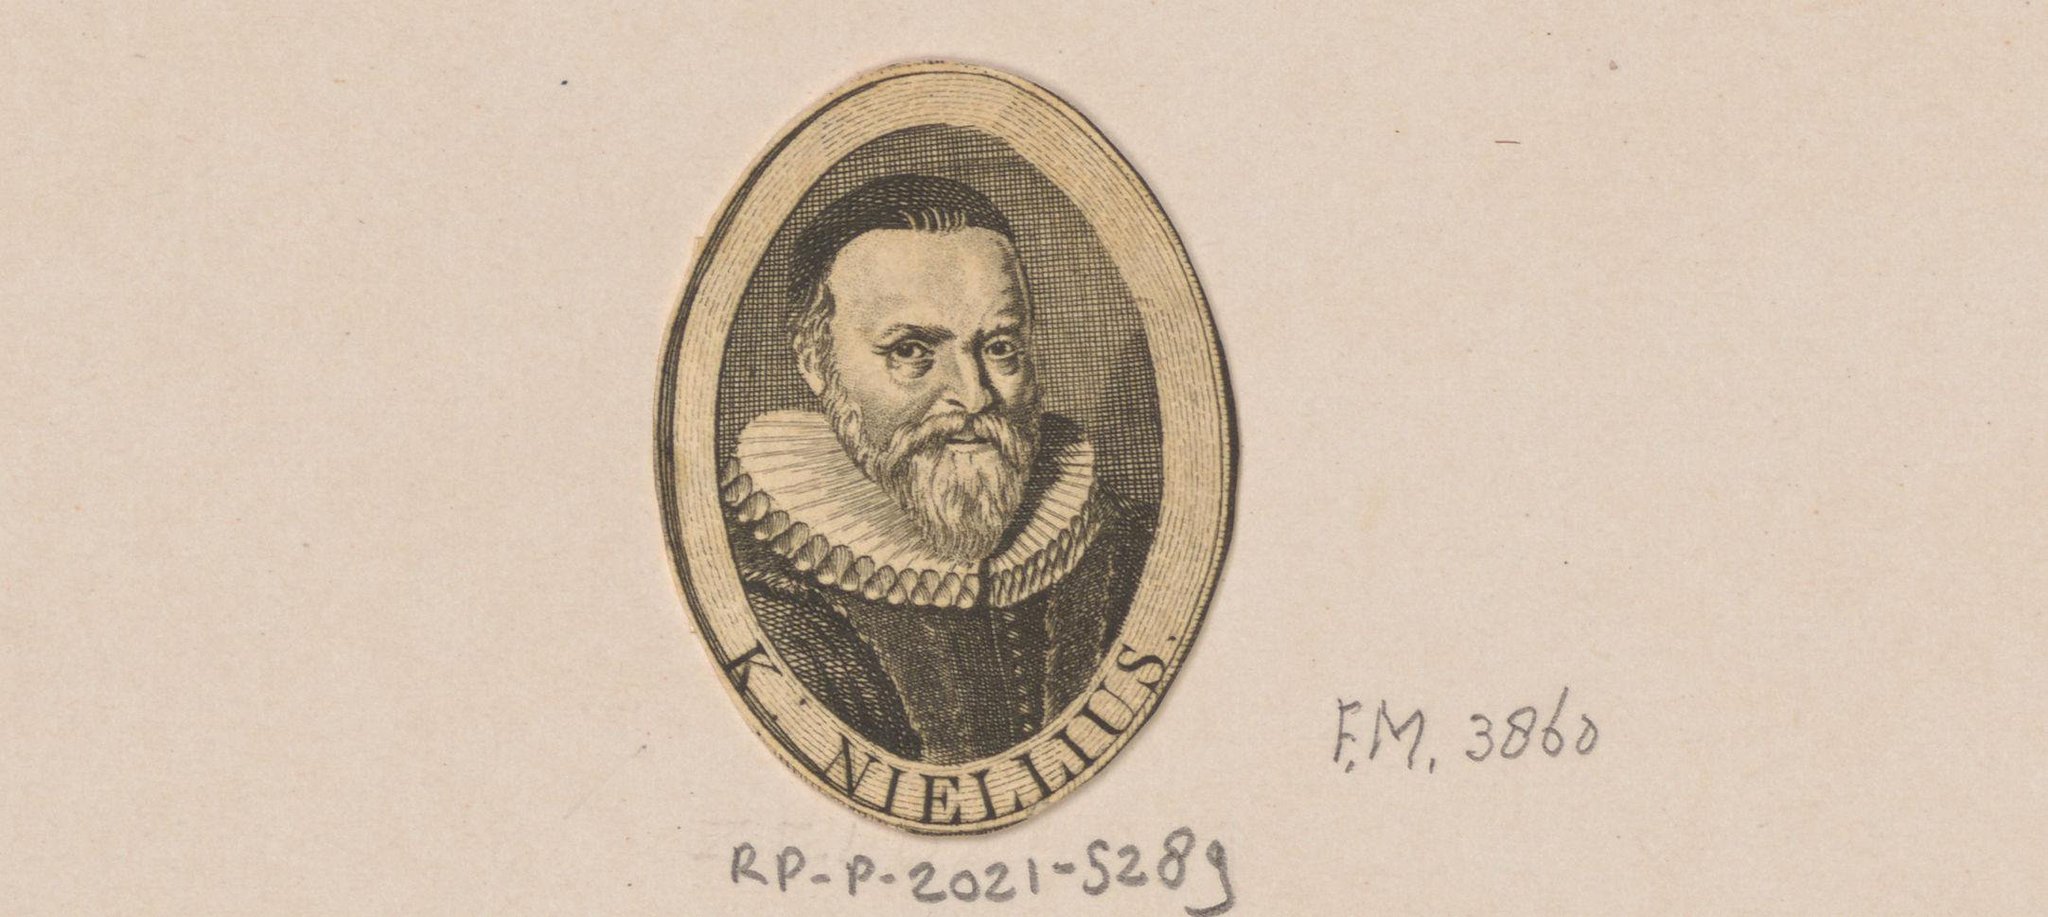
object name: print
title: Portret van Carolus Niellius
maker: Anonymous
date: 1650-1749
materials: paper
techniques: engraving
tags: theologian, historical persons